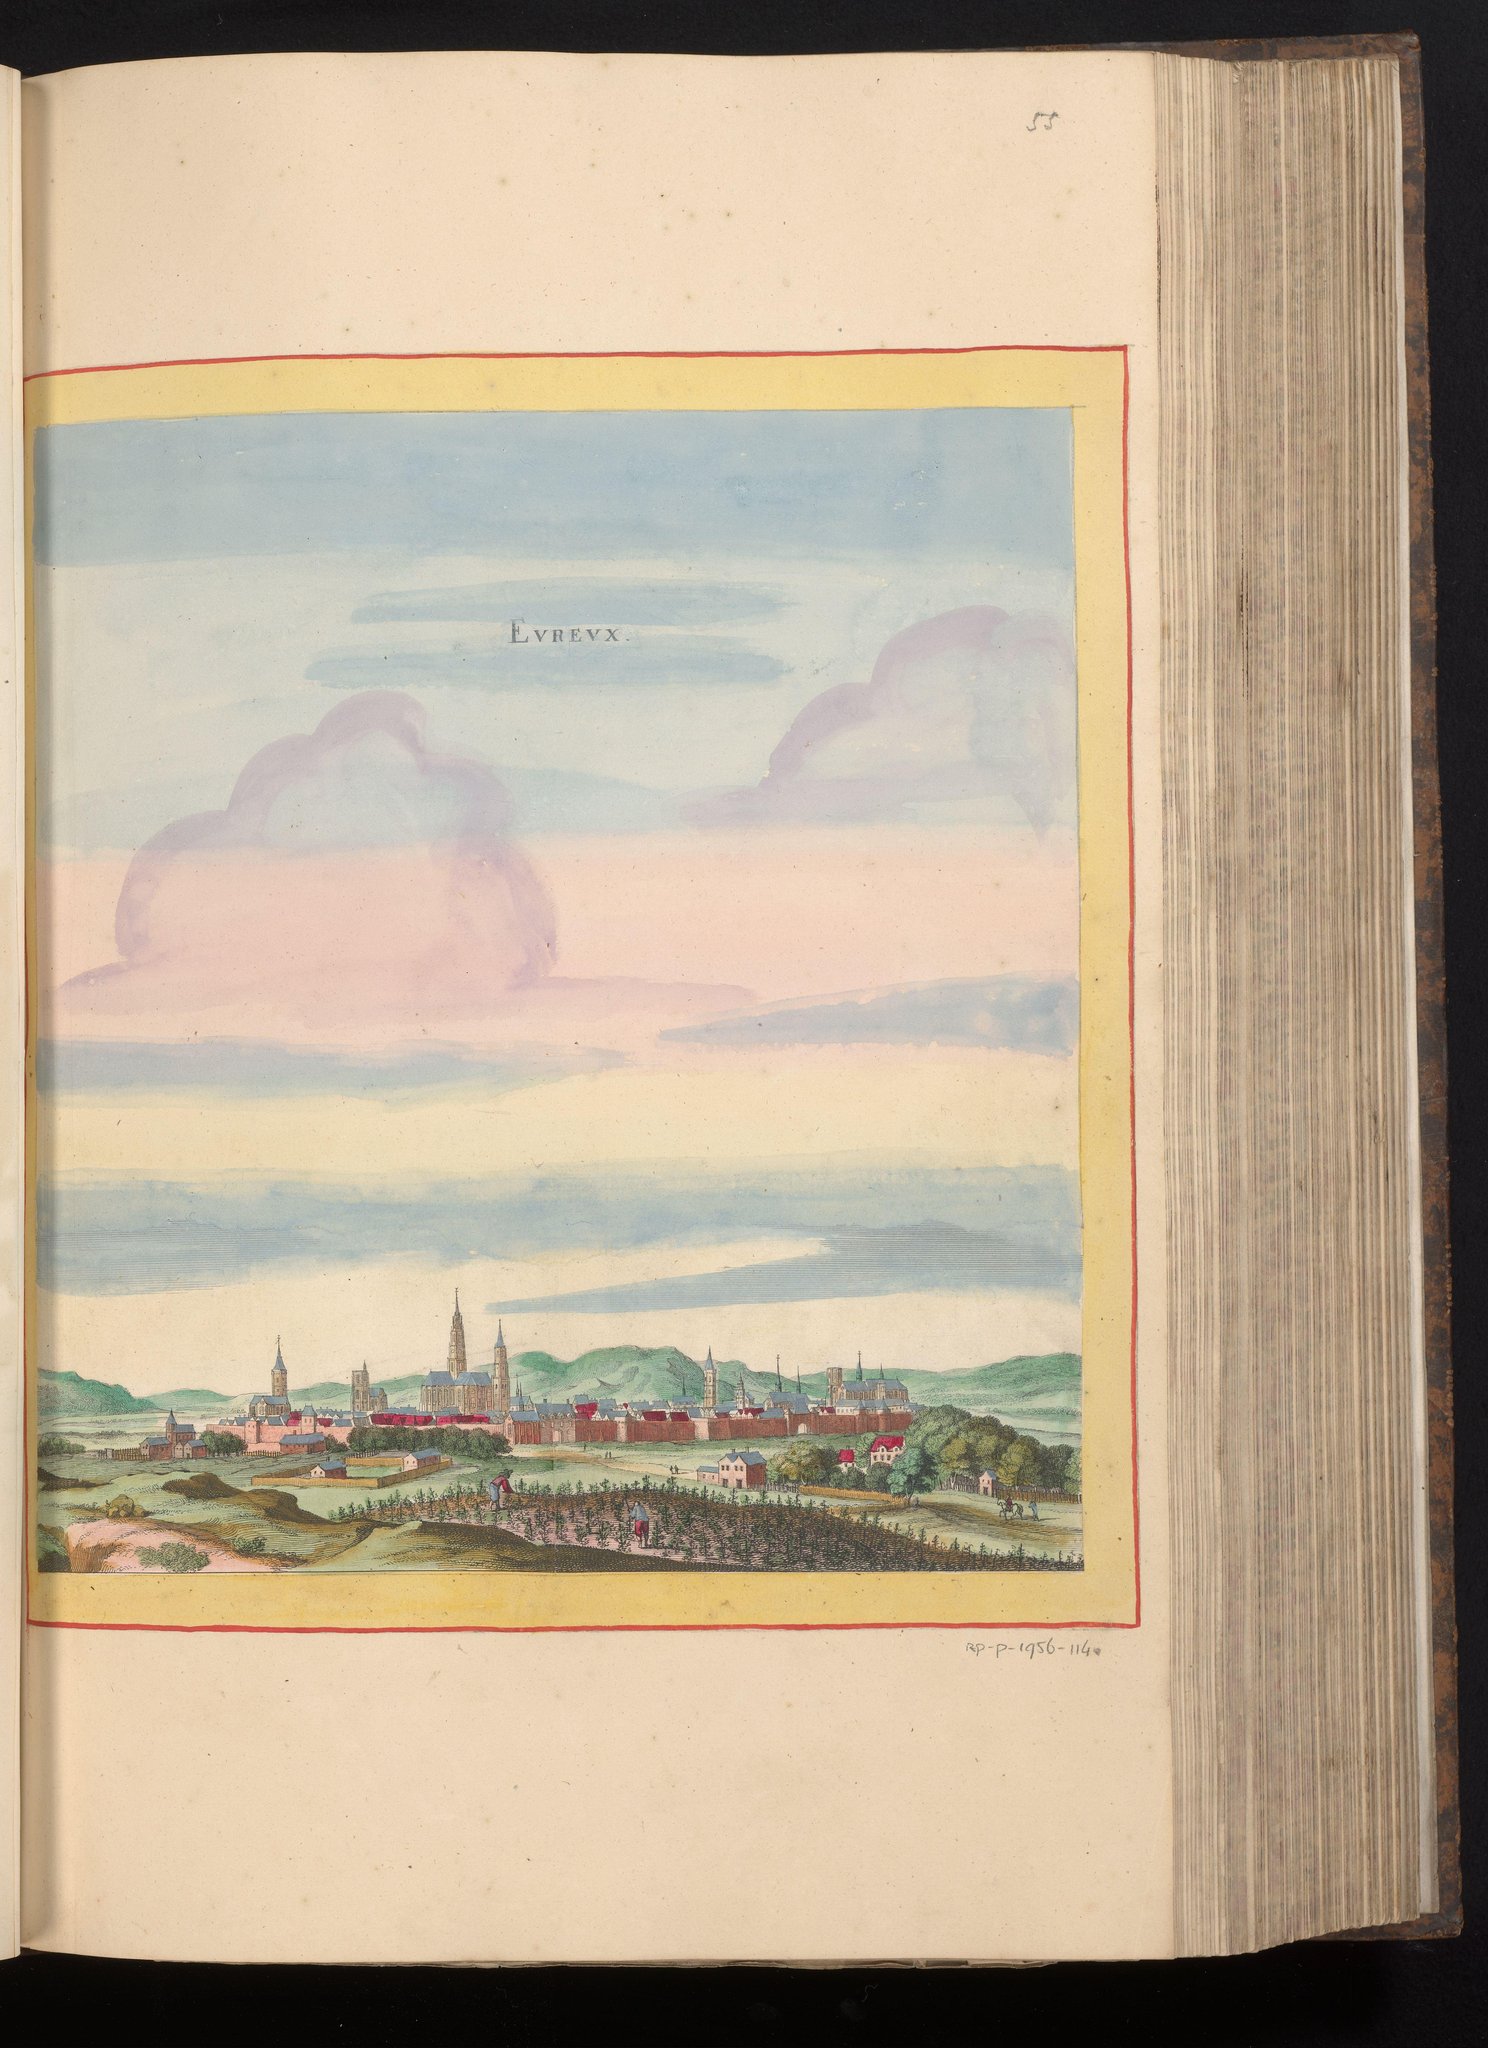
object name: print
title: Evreux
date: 1657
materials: paper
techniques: engraving, etching, hand coloring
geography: the hague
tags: village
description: Prent uit: Zeiller, Martin. Topographia Galliae. 13 dln. Frankfurt: Caspar Merian, 1657, dl. 8, na p. 16. De titel is uit de originele prent gesneden. Boven de gravure is een deel lucht en wolken (bij)geschilderd, waarin de titel gelijmd is. Origineel op één blad gedrukt met het gezicht op Dieppe (RP-P-1956-115).